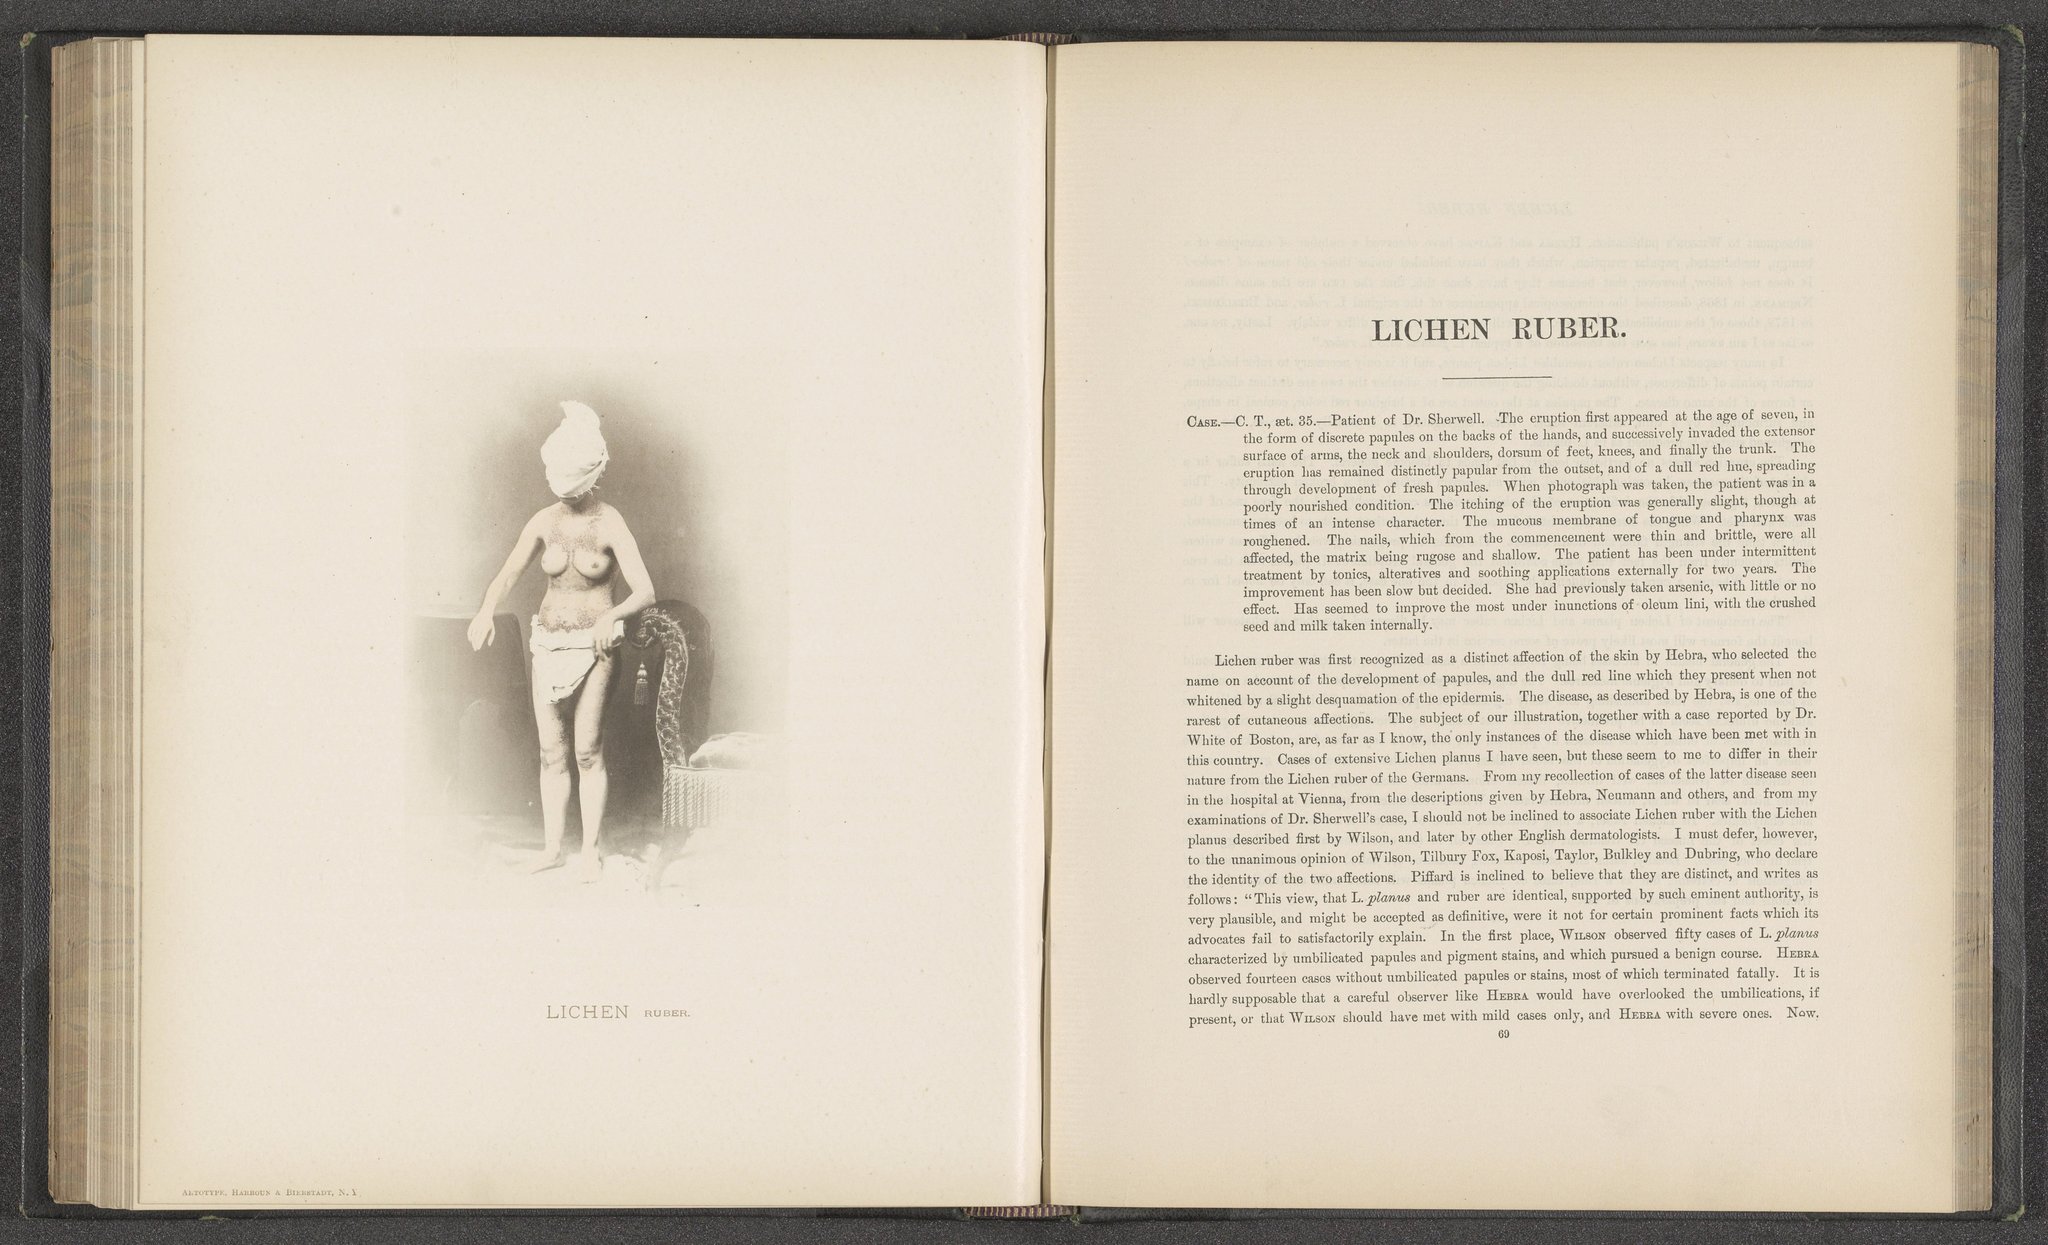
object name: page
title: Patiënt lijdend aan de huidziekte 'lichen ruber'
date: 1870-1881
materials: paper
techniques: photograph, hand coloring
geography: new york city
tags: adult woman, skin and venereal diseases